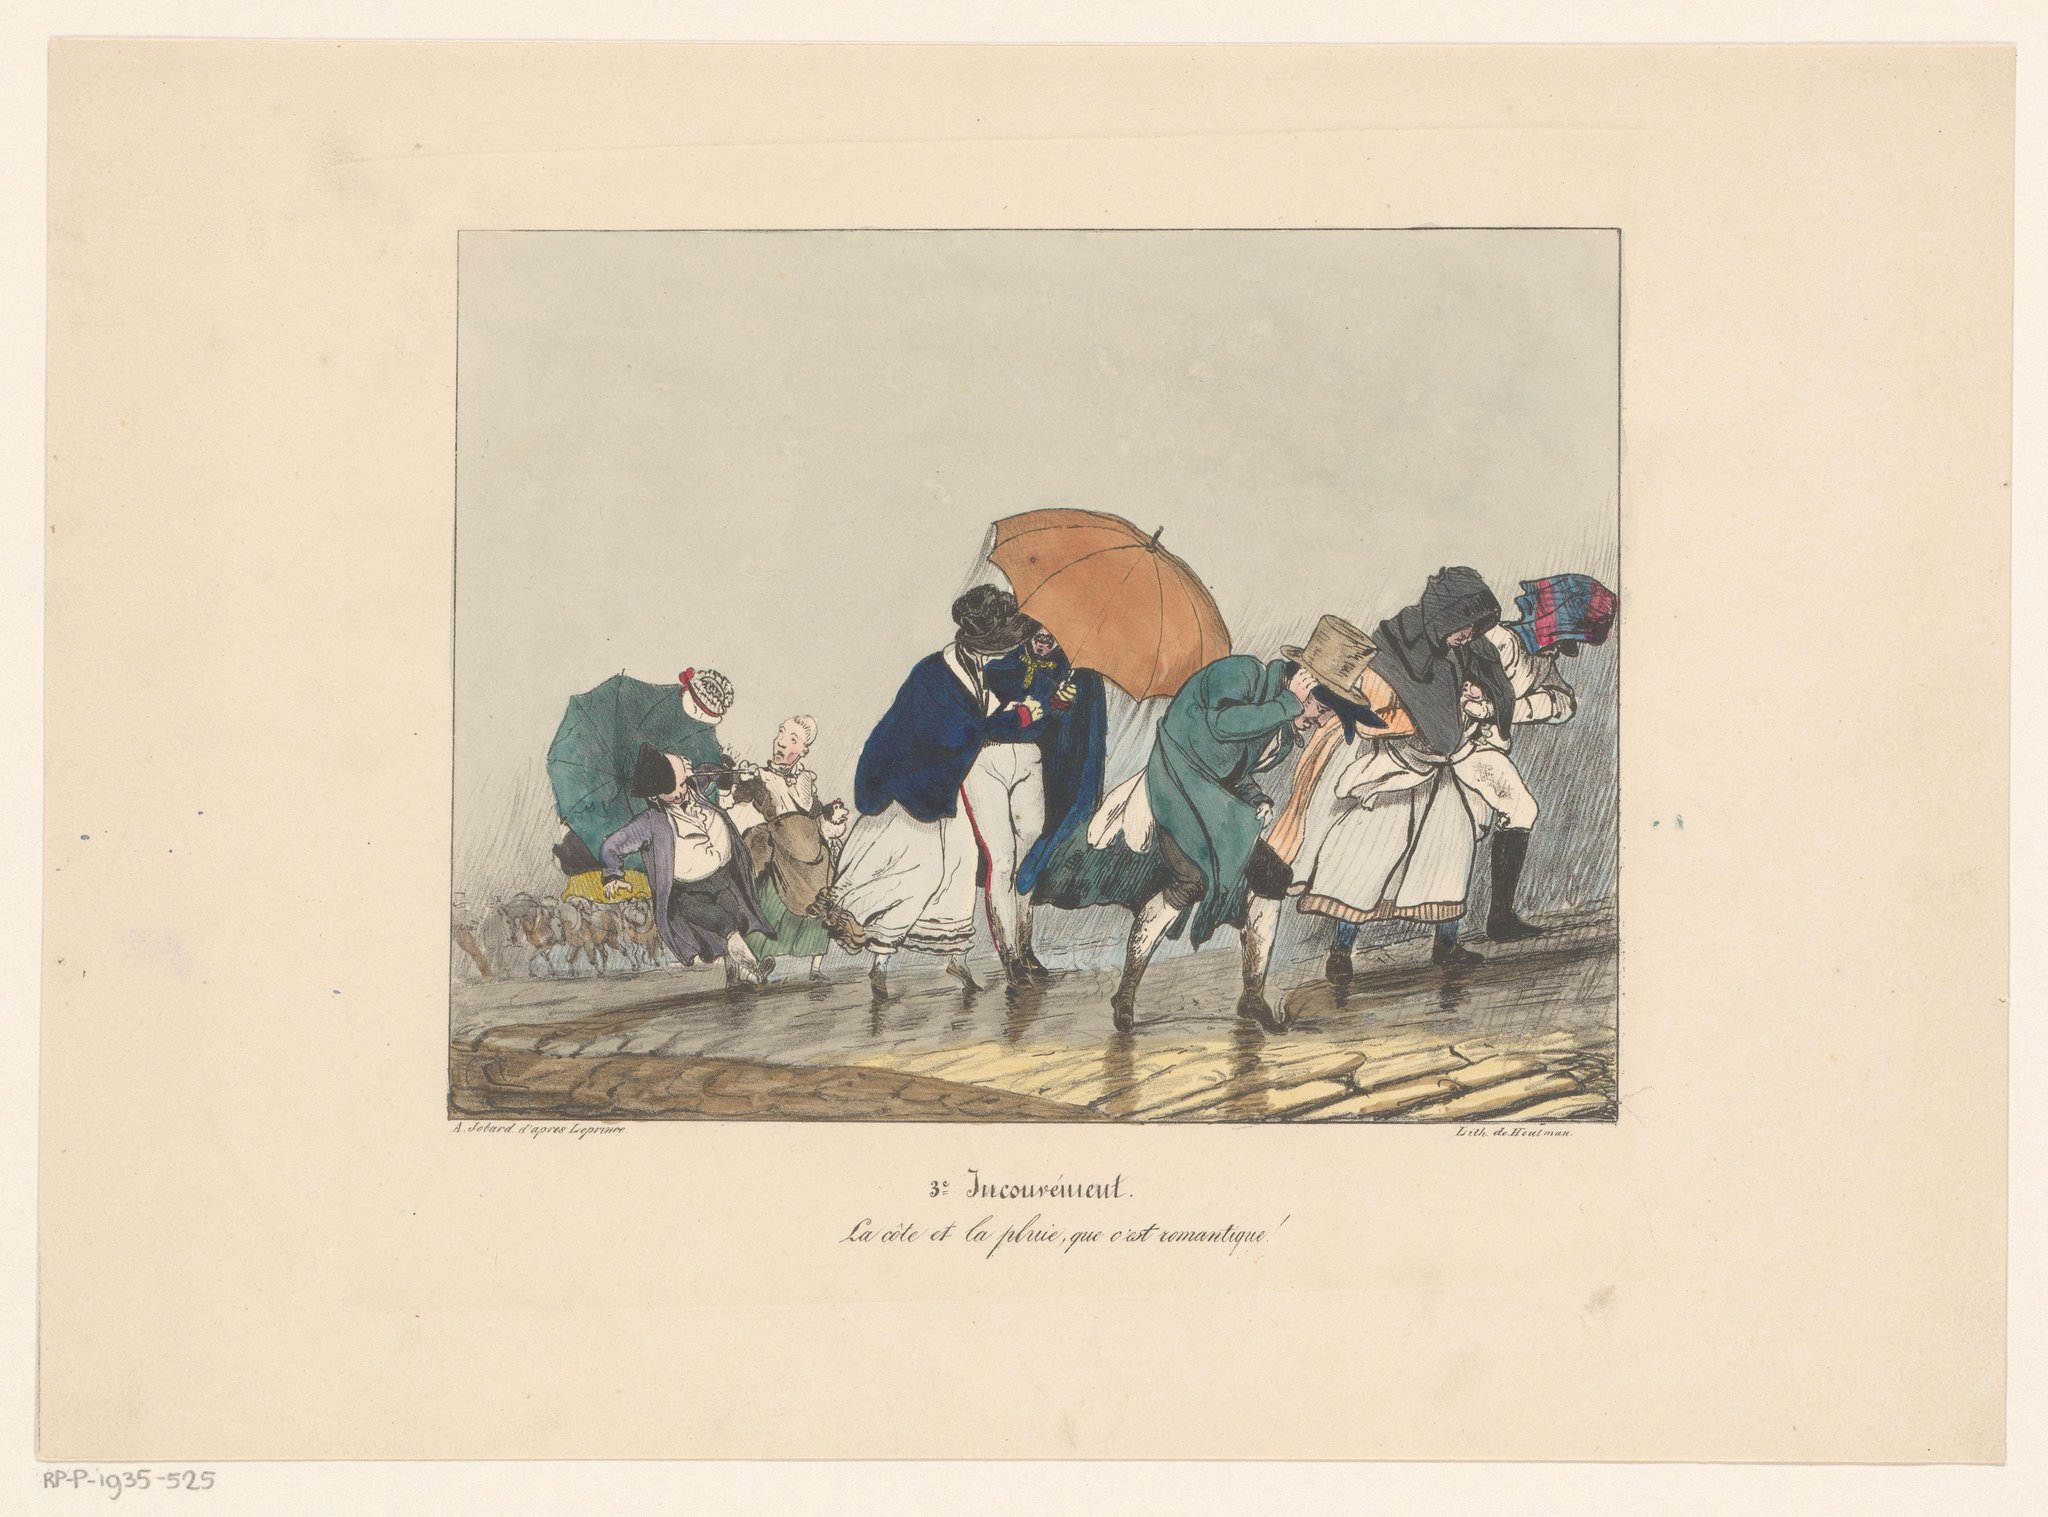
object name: print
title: Ongemakken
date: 1826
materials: paper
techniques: hand coloring, lithograph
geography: utrecht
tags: downpour, rain shower, umbrella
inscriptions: collector's mark: Lugt 2760, collector's mark: Lugt 2228